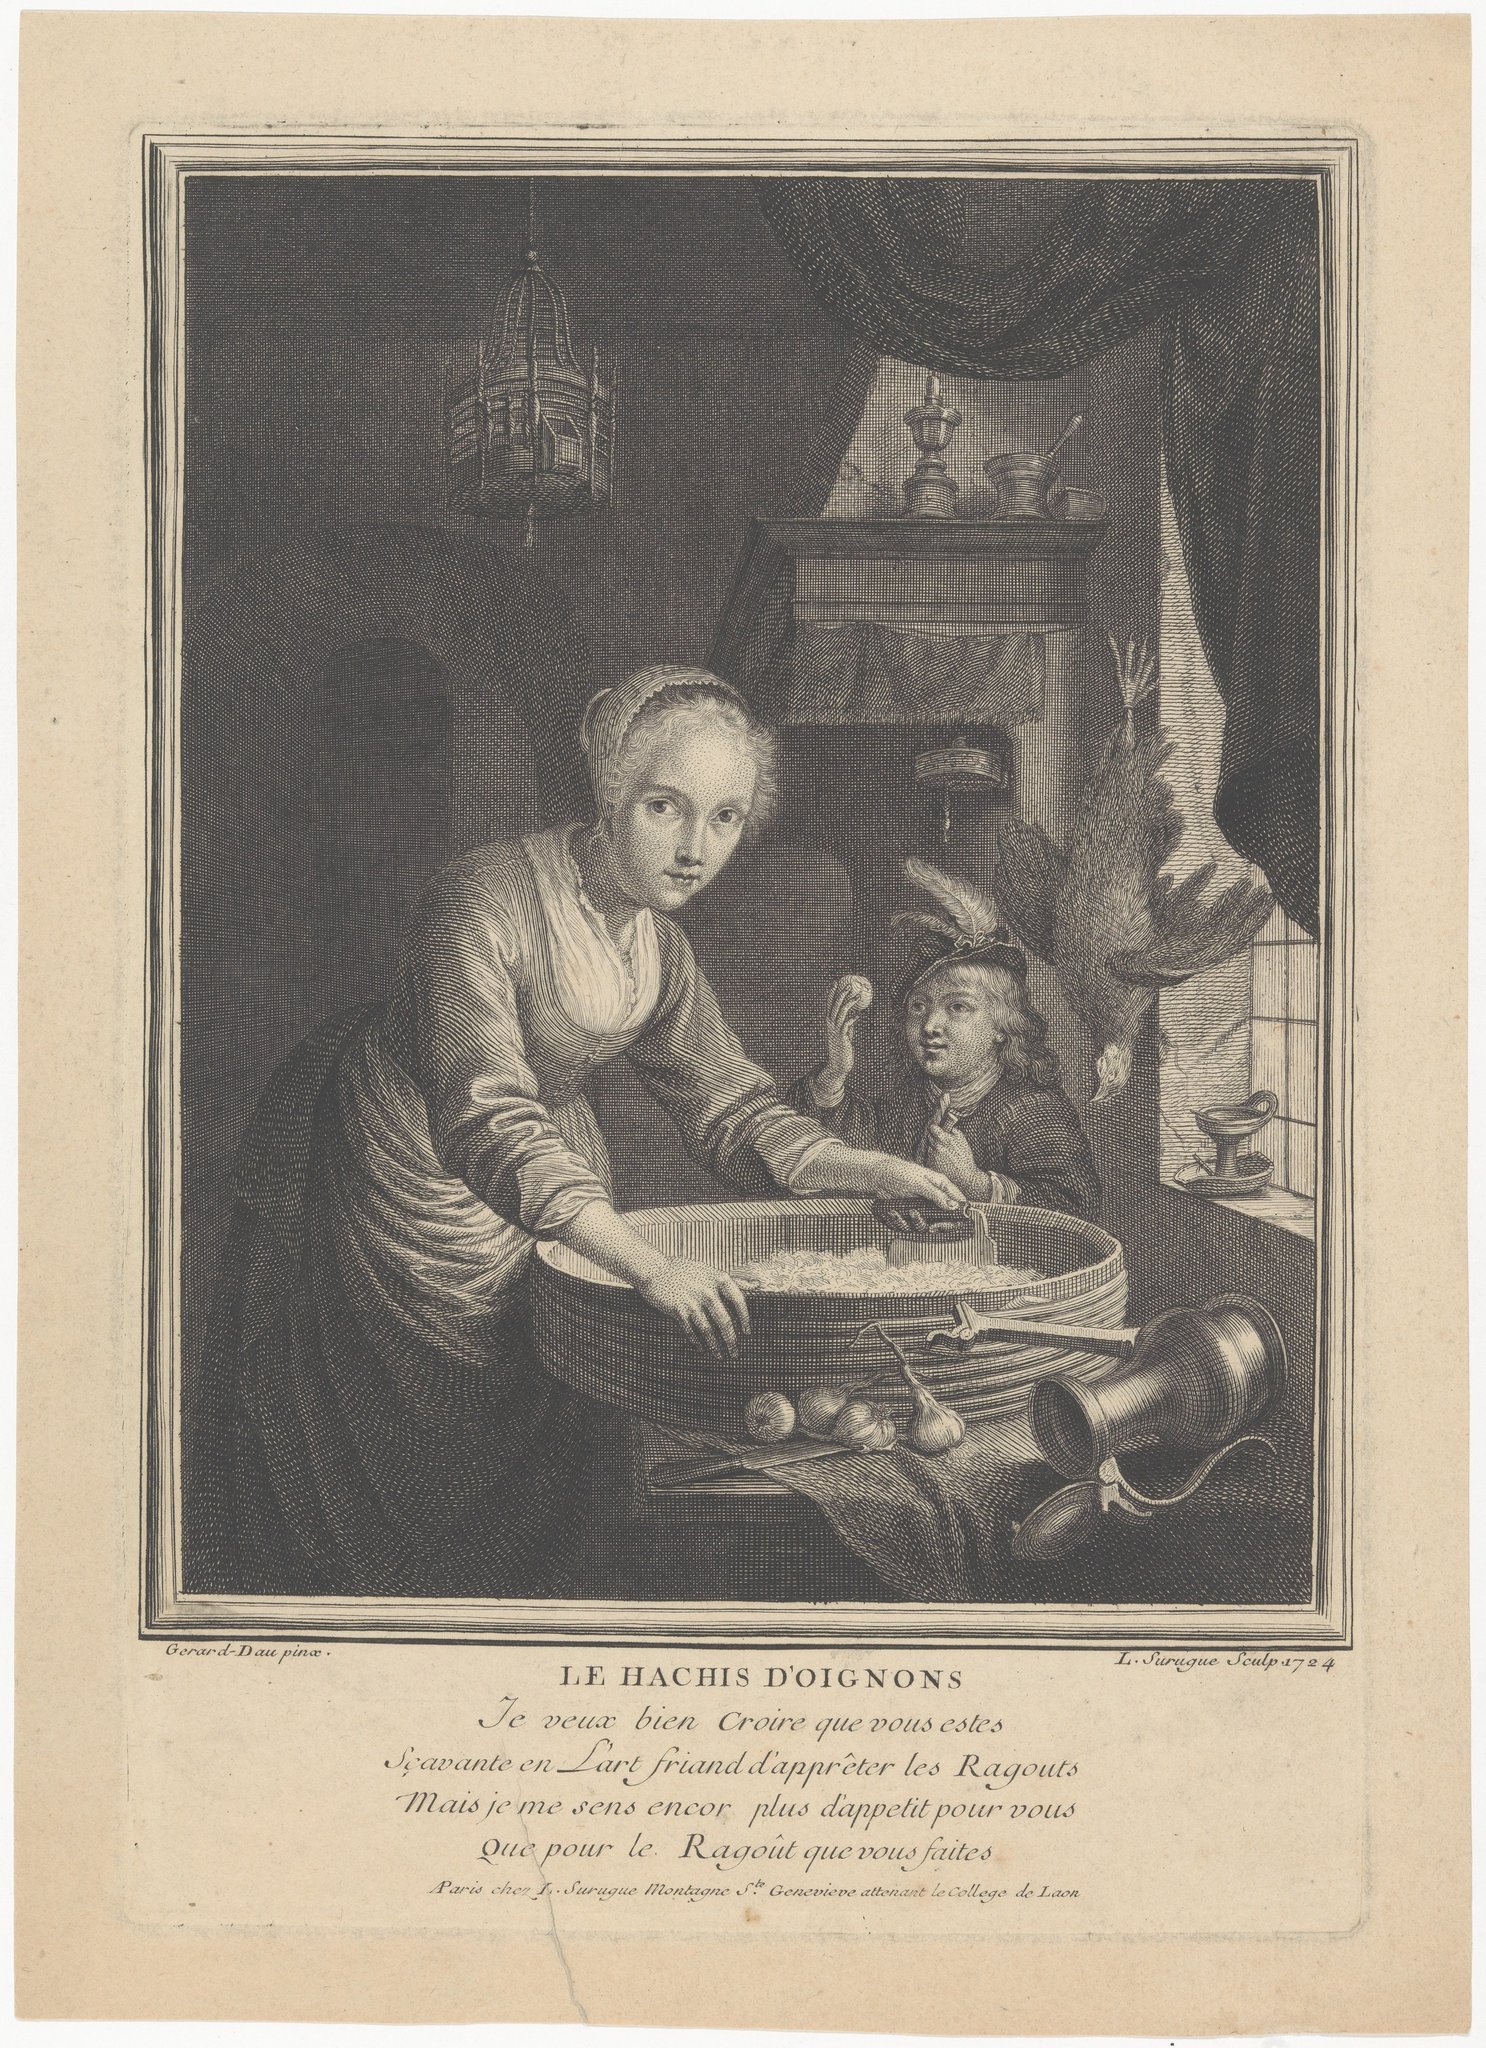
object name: print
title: Young Woman Chopping Onions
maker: louis surugue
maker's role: artist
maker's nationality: french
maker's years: 1686-1762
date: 1724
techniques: engraving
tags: food,birds,onions,children,women,cooking